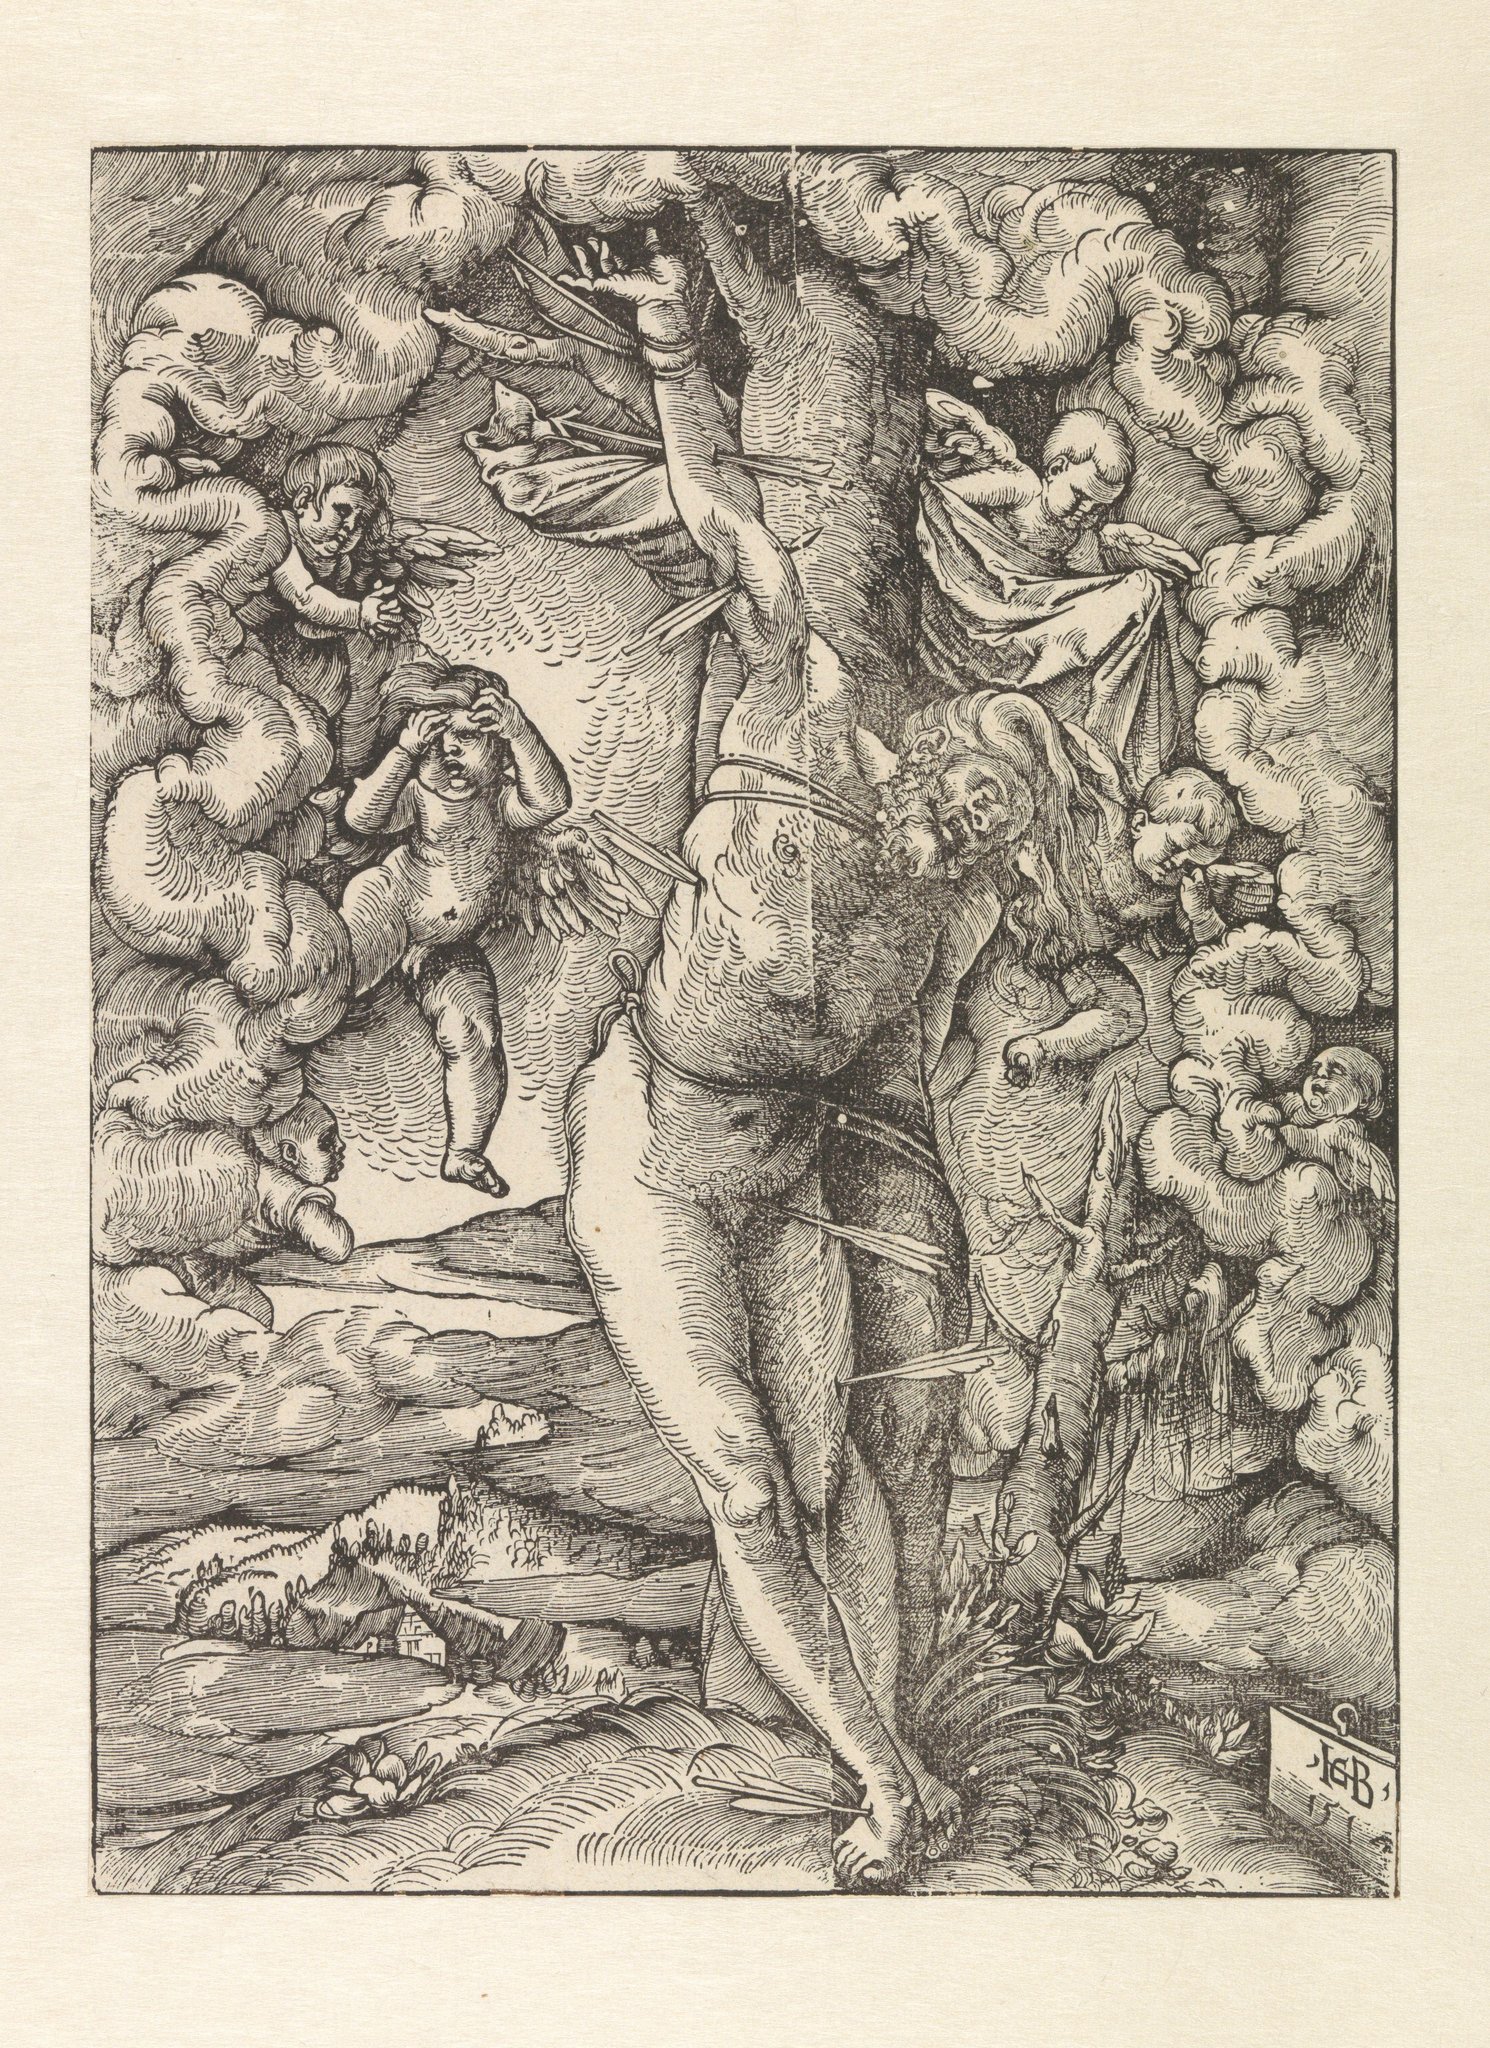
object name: print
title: Sebastiaan vastgebonden en met pijlen in zijn lichaam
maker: hans baldung grien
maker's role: draughtsman, print maker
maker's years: 1484-1545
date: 1514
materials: paper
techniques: woodcut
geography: freiburg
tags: st. sebastian succoured by angels, who untie him from the tree or pillar and remove the arrows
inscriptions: collector's mark: Lugt 2228a, collector's mark: Lugt 240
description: De heilige Sebastiaan staat met touwen vastgebonden aan een boom en hij heeft verschillende pijlen in zijn lichaam. In een landschap wordt hij omringd door kleine engelen die hem te hulp komen.